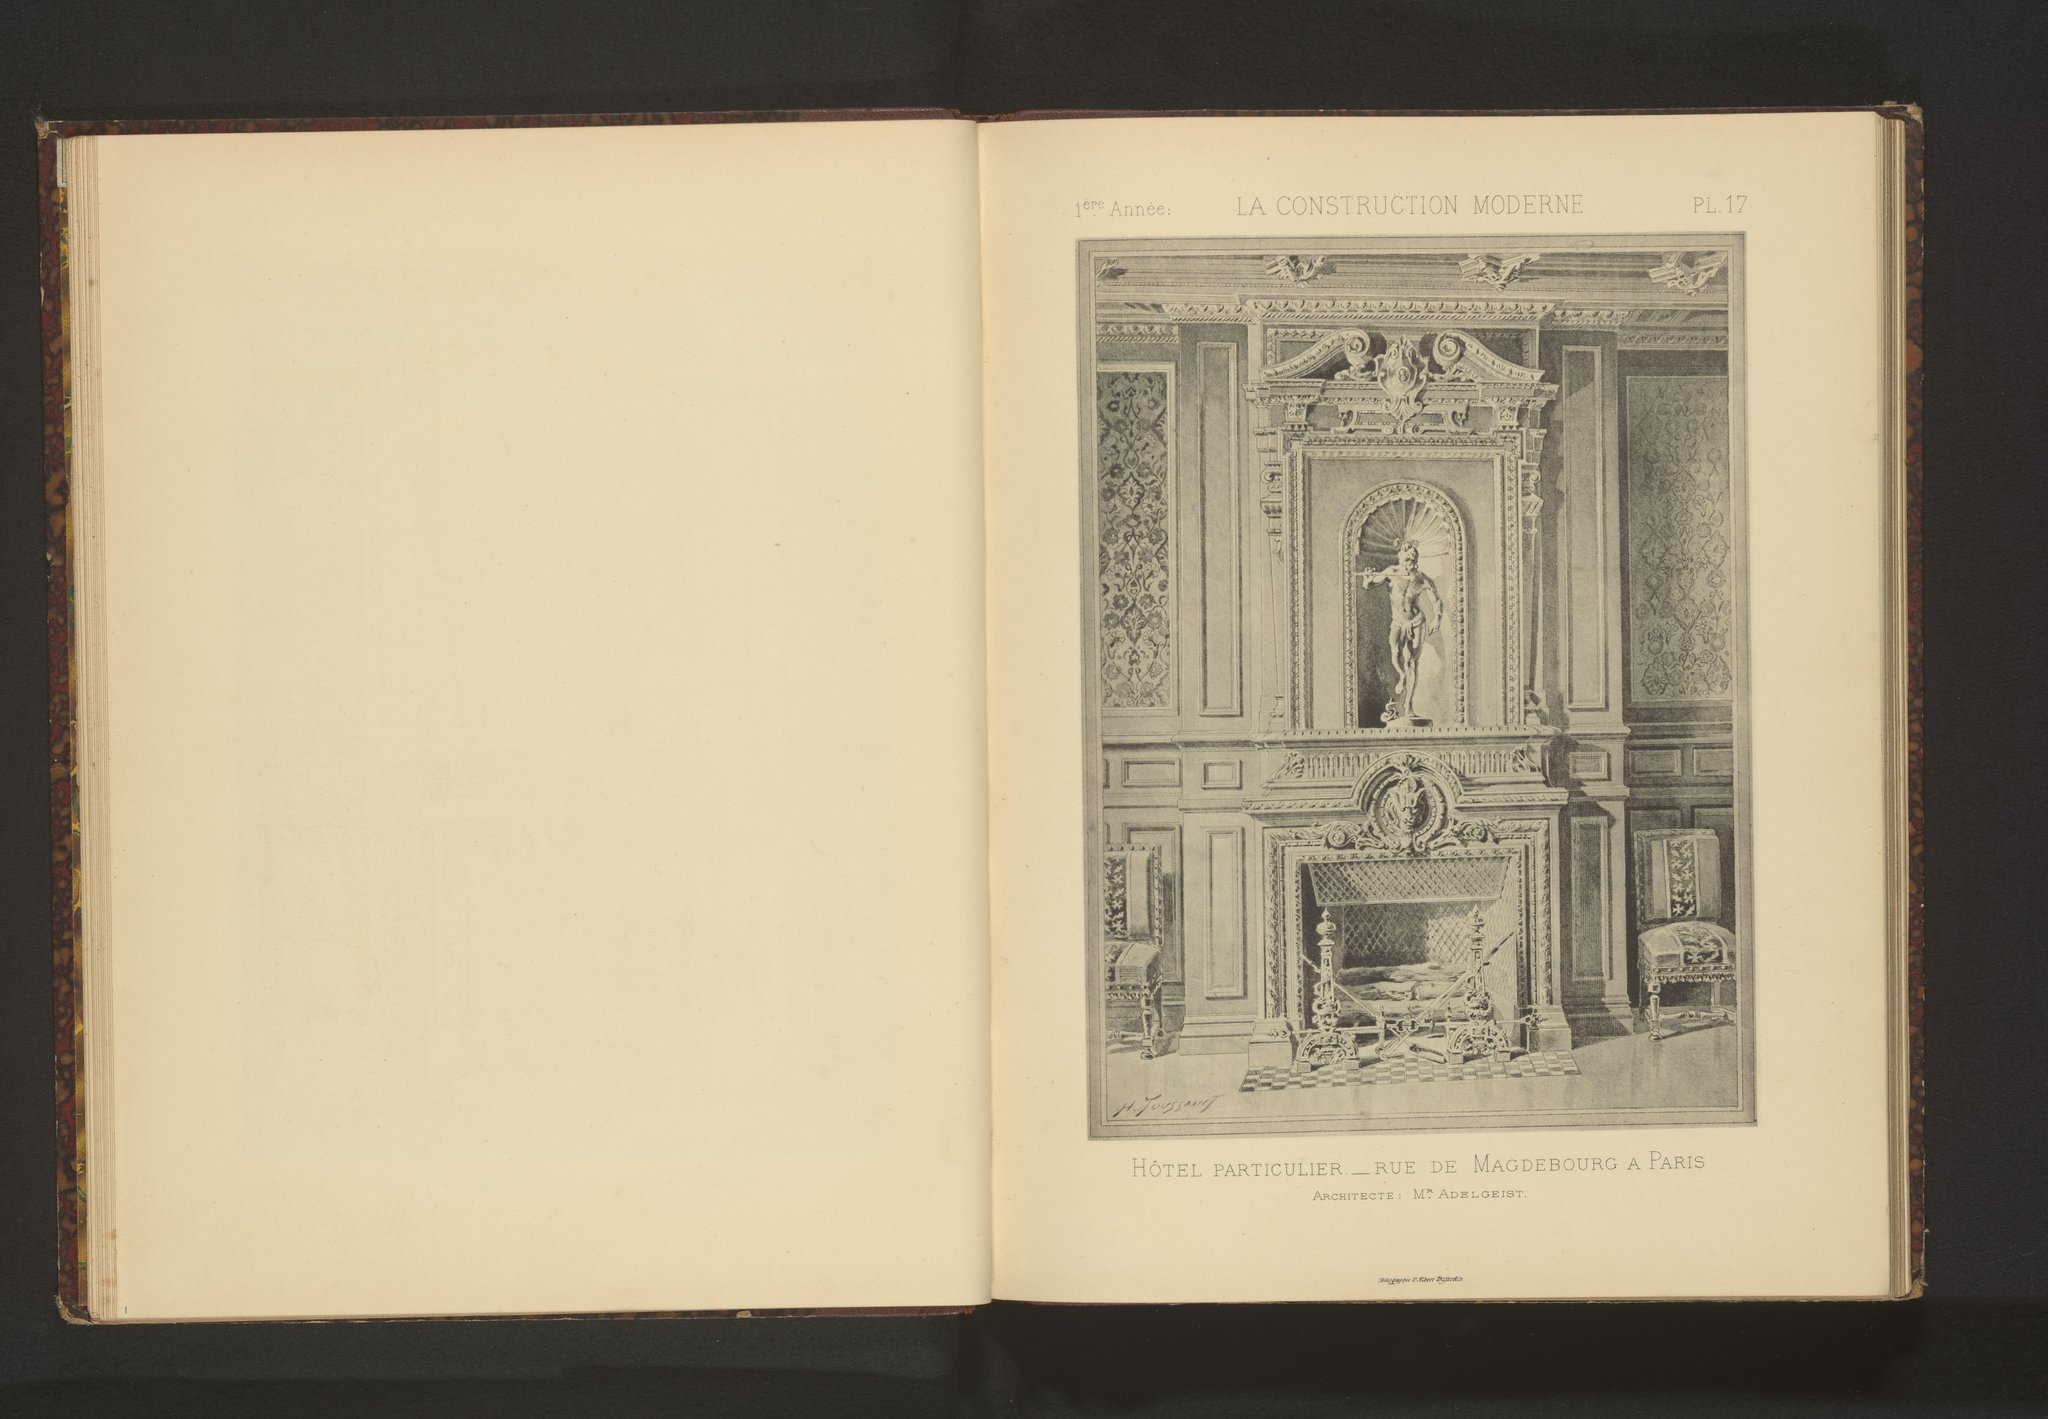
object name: page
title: Reproductie van een prent van een schoorsteenmantel in een stadspaleis aan de Rue de Magdebourg in Parijs door H. Toussaint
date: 1881-1886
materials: paper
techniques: photograph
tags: chimney-piece, mantelpiece, foliage, tendrils, branches ~ ornament, paris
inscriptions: inscription: ‘1ère Année: LA CONSTRUCTION MODERNE Pl. 17’, inscription: ‘Architecte: Mr. Adelgeist.’